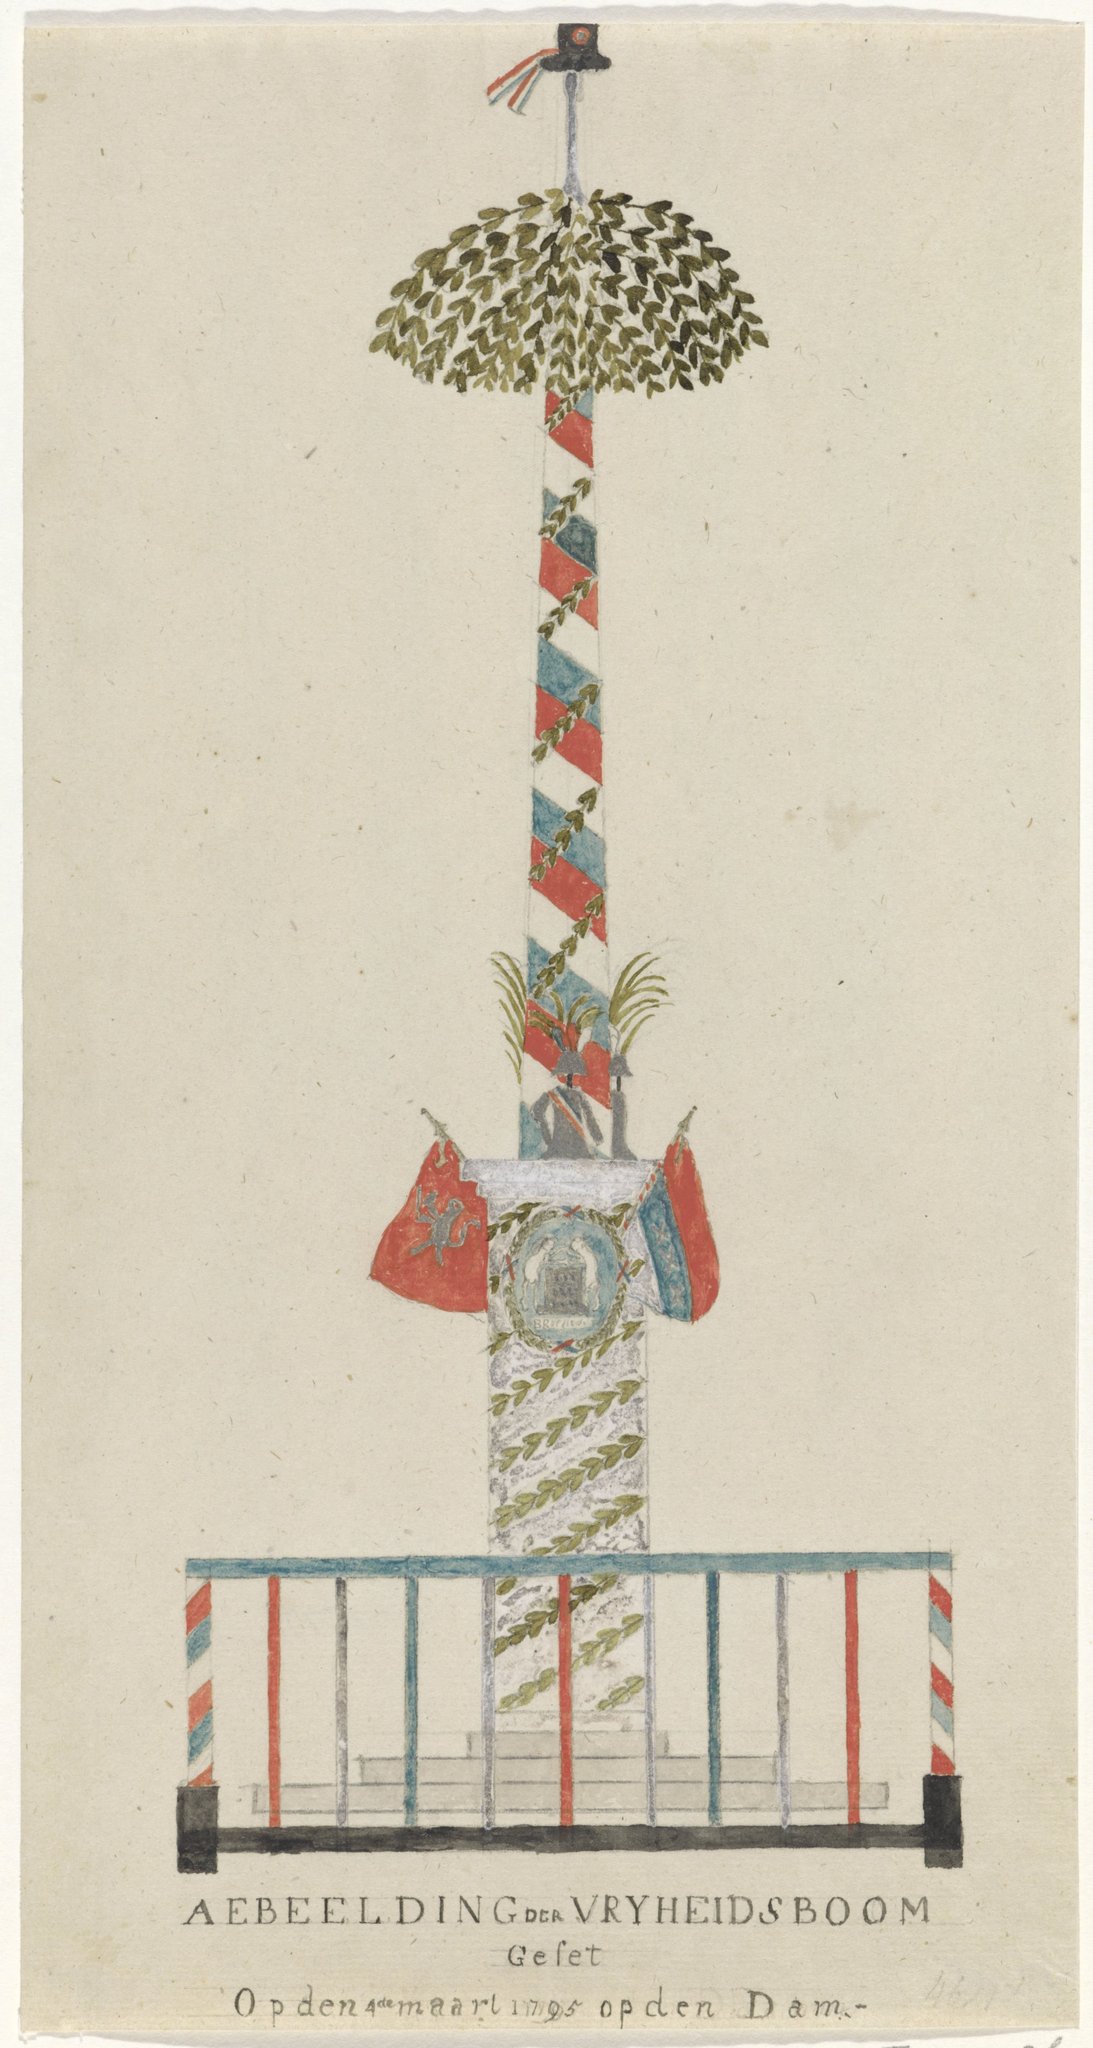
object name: drawing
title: Afbeelding der Vryheidsboom Geset Op den 4de maart 1795 op den Dam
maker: Anonymous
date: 1795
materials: paint, paper, pencil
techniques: brush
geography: netherlands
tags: dancing around the tree of liberty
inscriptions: collector's mark: Lugt 2228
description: De vrijheidsboom ingewijd op 4 maart 1795 op de Dam te Amsterdam.